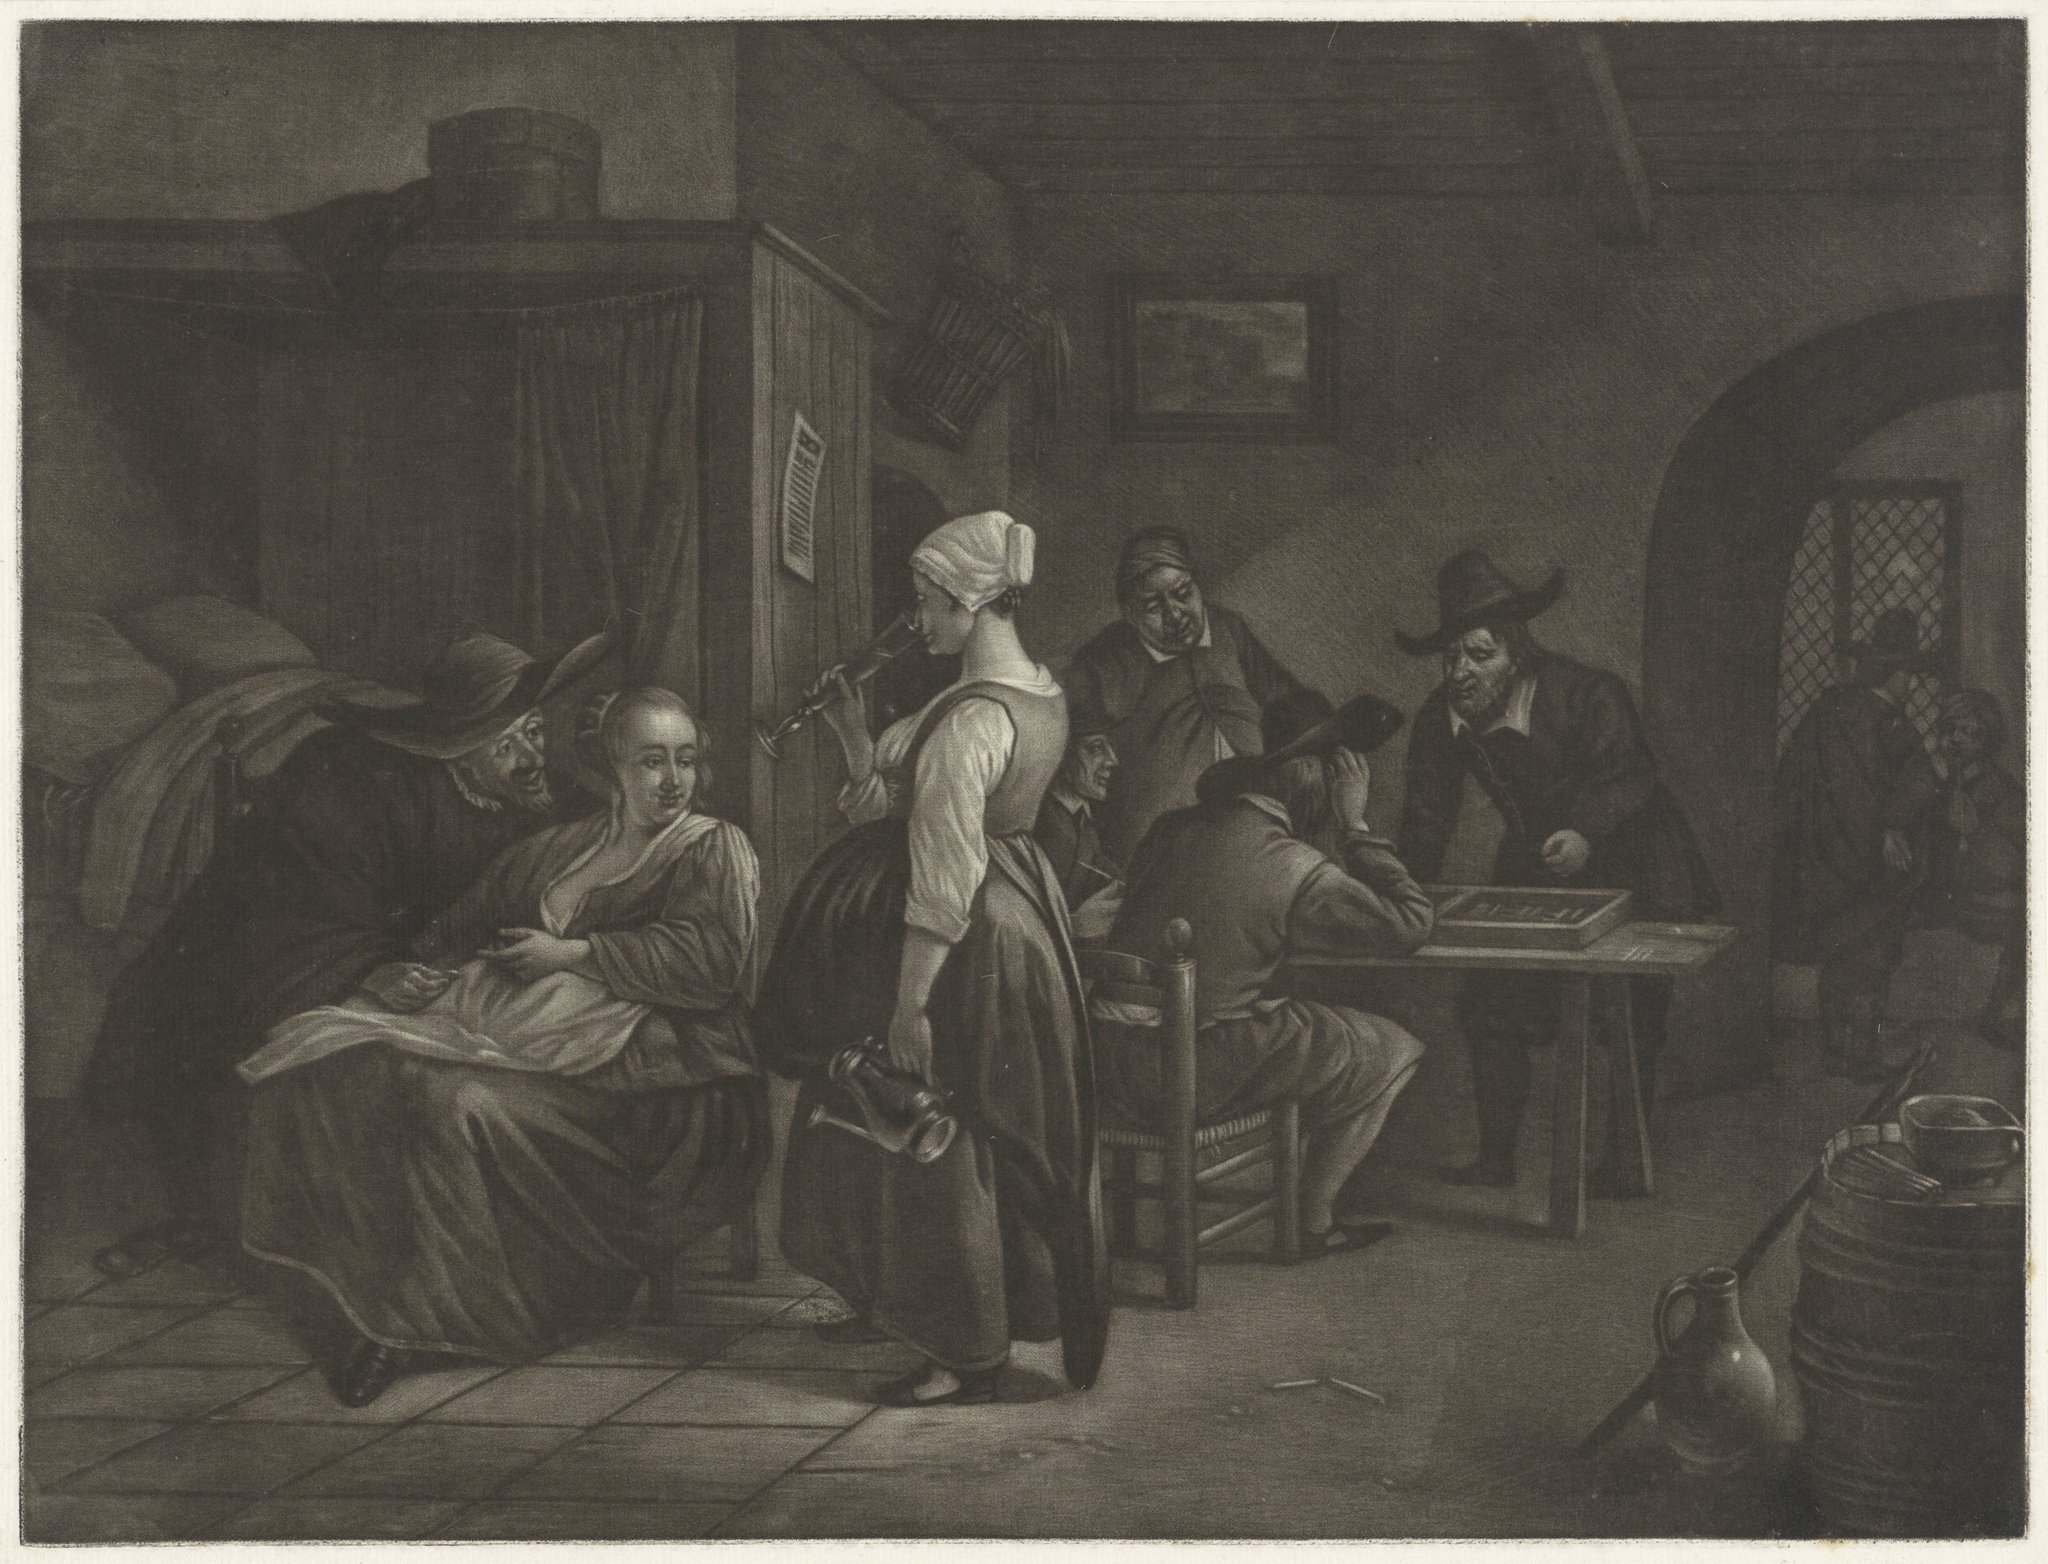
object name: print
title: Herbergscène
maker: jan stolker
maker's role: draughtsman, painter, print maker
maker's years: 1724-1785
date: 1734-1785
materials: paper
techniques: mezzotint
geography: northern netherlands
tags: inn, coffee-house, public house, etc., picture, painting, prostitution, board-games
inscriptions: collector's mark: Lugt 240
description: In een herberg neemt een vrouw een slok uit een fluitglas terwijl ze toekijkt hoe een man een vrouw een geldstuk aanbiedt. Op de achtergrond zitten vier mannen te spelen rond een tafel. Aan de muur hangt een schilderij.